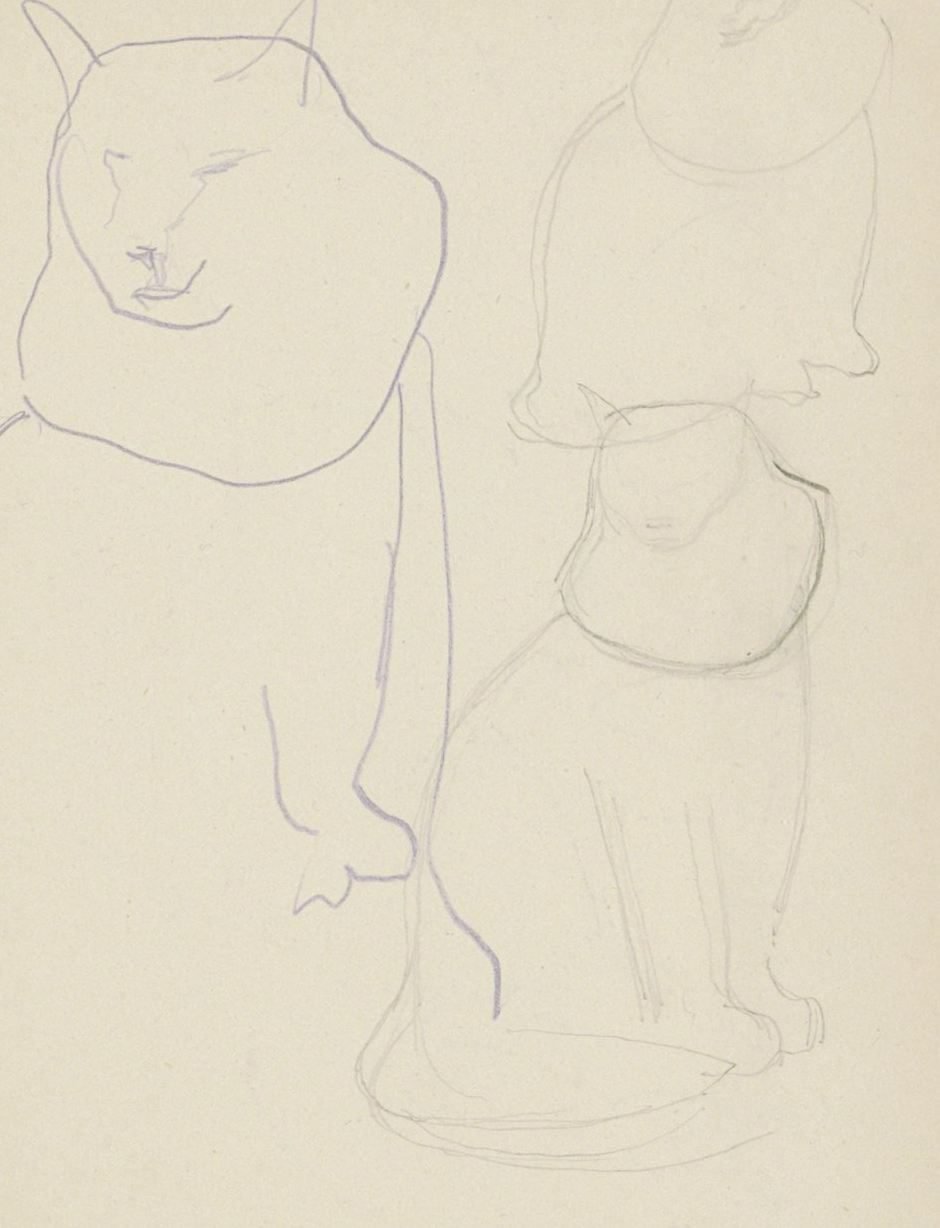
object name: sketchbook leaf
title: Drie zittende beren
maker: reijer stolk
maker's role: draughtsman, print maker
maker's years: 1896-1945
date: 1906-1945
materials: paper, pencil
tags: beasts of prey, predatory animals: bear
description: Blad 42 recto uit een schetsboek met 69 bladen.